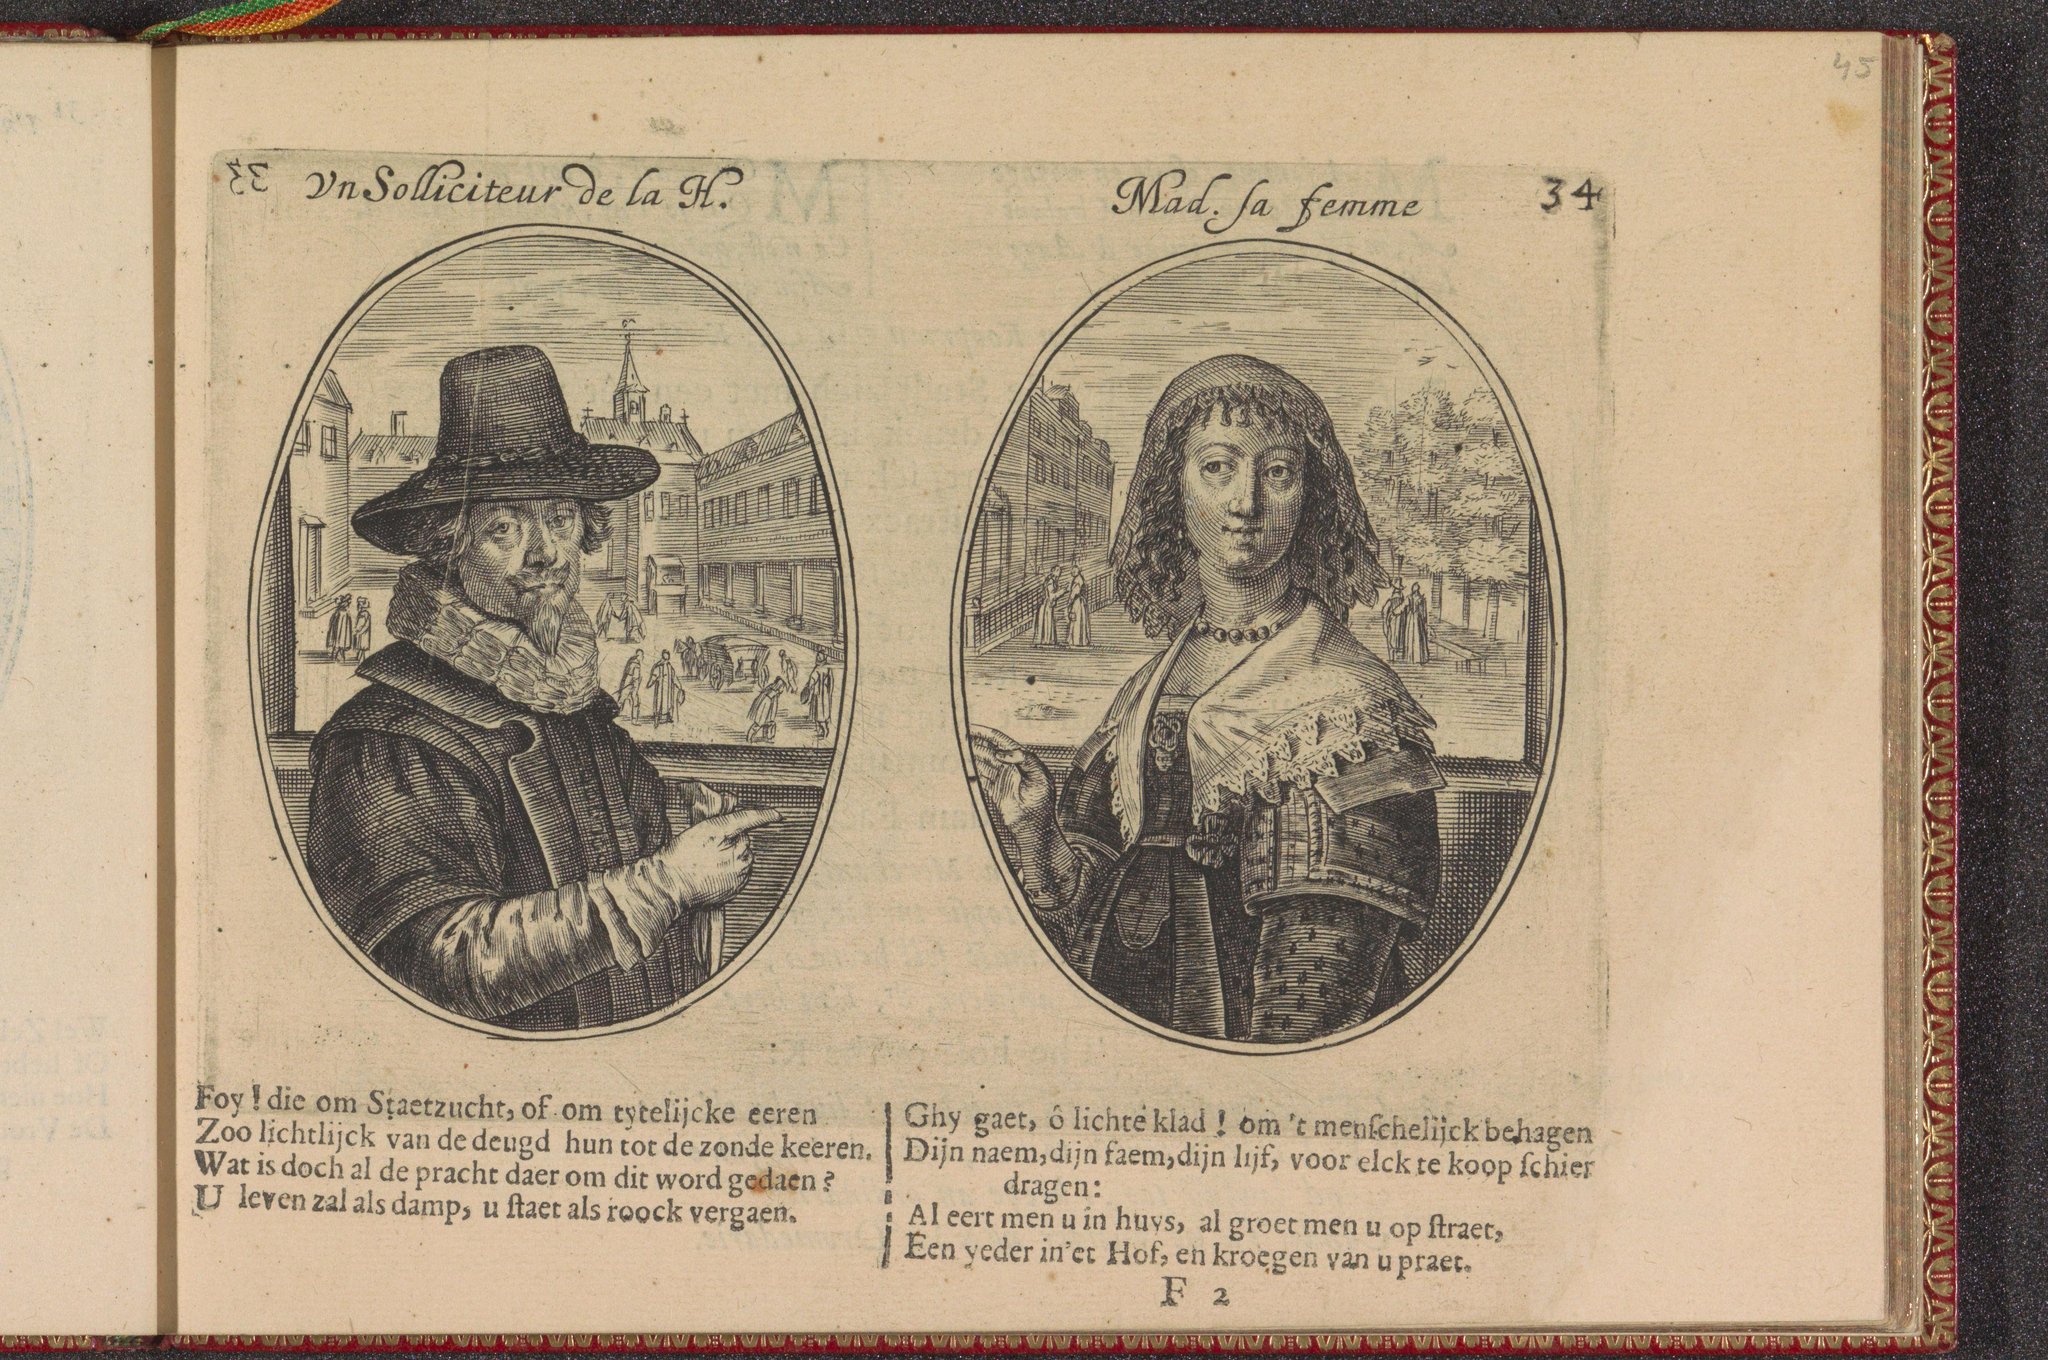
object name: print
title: Un solliciteur de la H. / Mad. sa femme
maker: crispijn van de passe (ii)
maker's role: draughtsman, print maker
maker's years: 1594-1670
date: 1641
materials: paper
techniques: engraving, letterpress printing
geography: amsterdam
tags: city-view, and landscape with man-made constructions, female sex; woman, male sex; man, the hague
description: Twee voorstellingen op een albumblad. Links het fictieve portret van een solliciteur uit Den Haag, een pleitbezorger van kleine rechtzaken. Achter hem een gezicht op het Binnenhof. Rechts zijn vrouw met op de achtergrond mogelijk het Lange Voorhout. Daaronder twee kwatrijnen in het Nederlands. De prent maakt deel uit van een album.